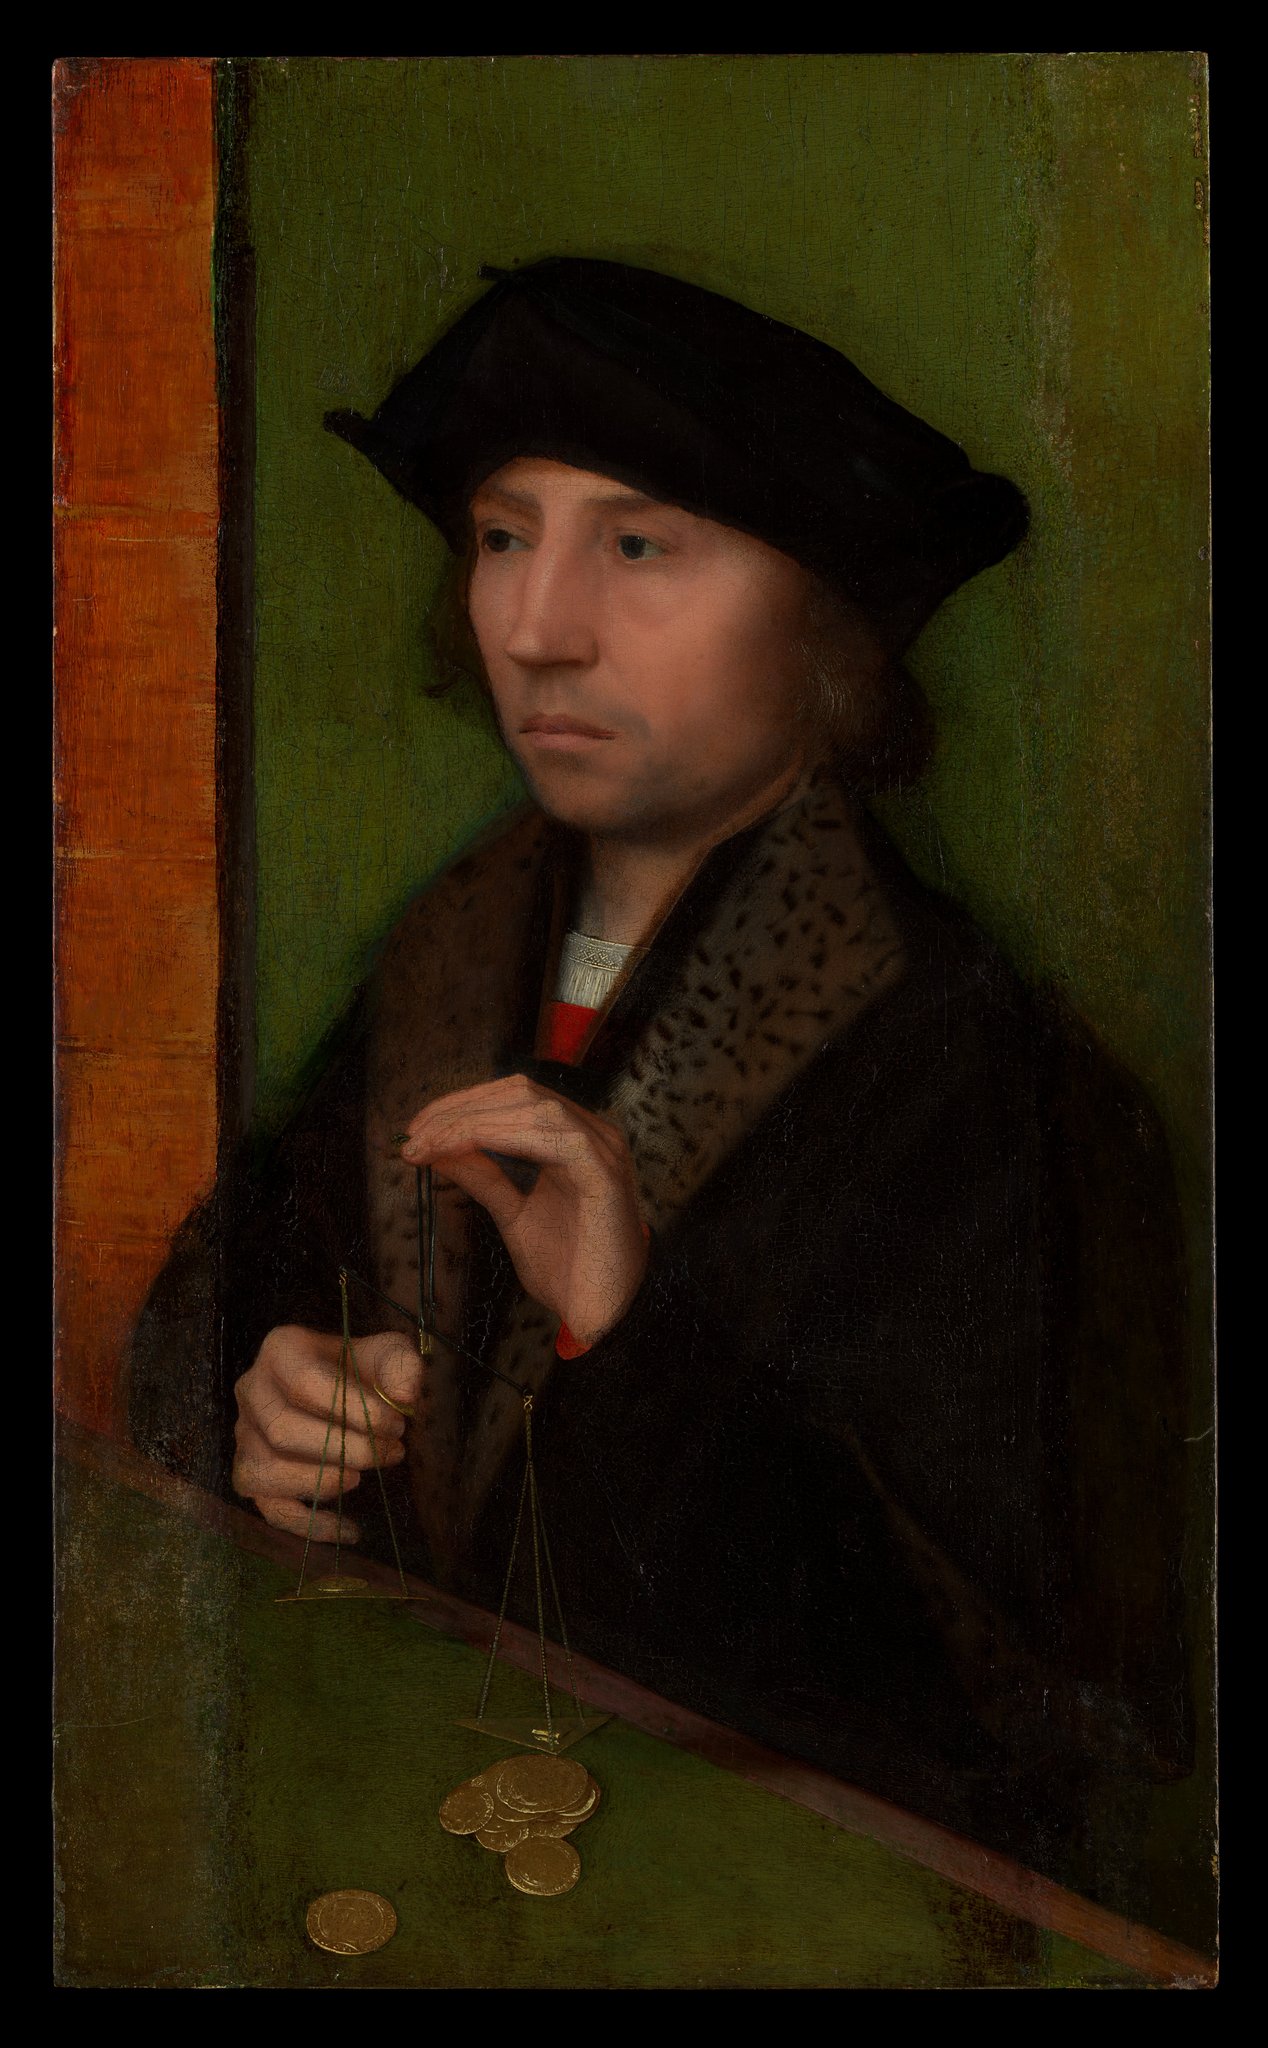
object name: painting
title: Man Weighing Gold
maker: adriaen isenbrant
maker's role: artist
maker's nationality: netherlandish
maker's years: 1510-1551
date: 1515-1520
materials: oil, wood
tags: men,portraits,coins,money,scales